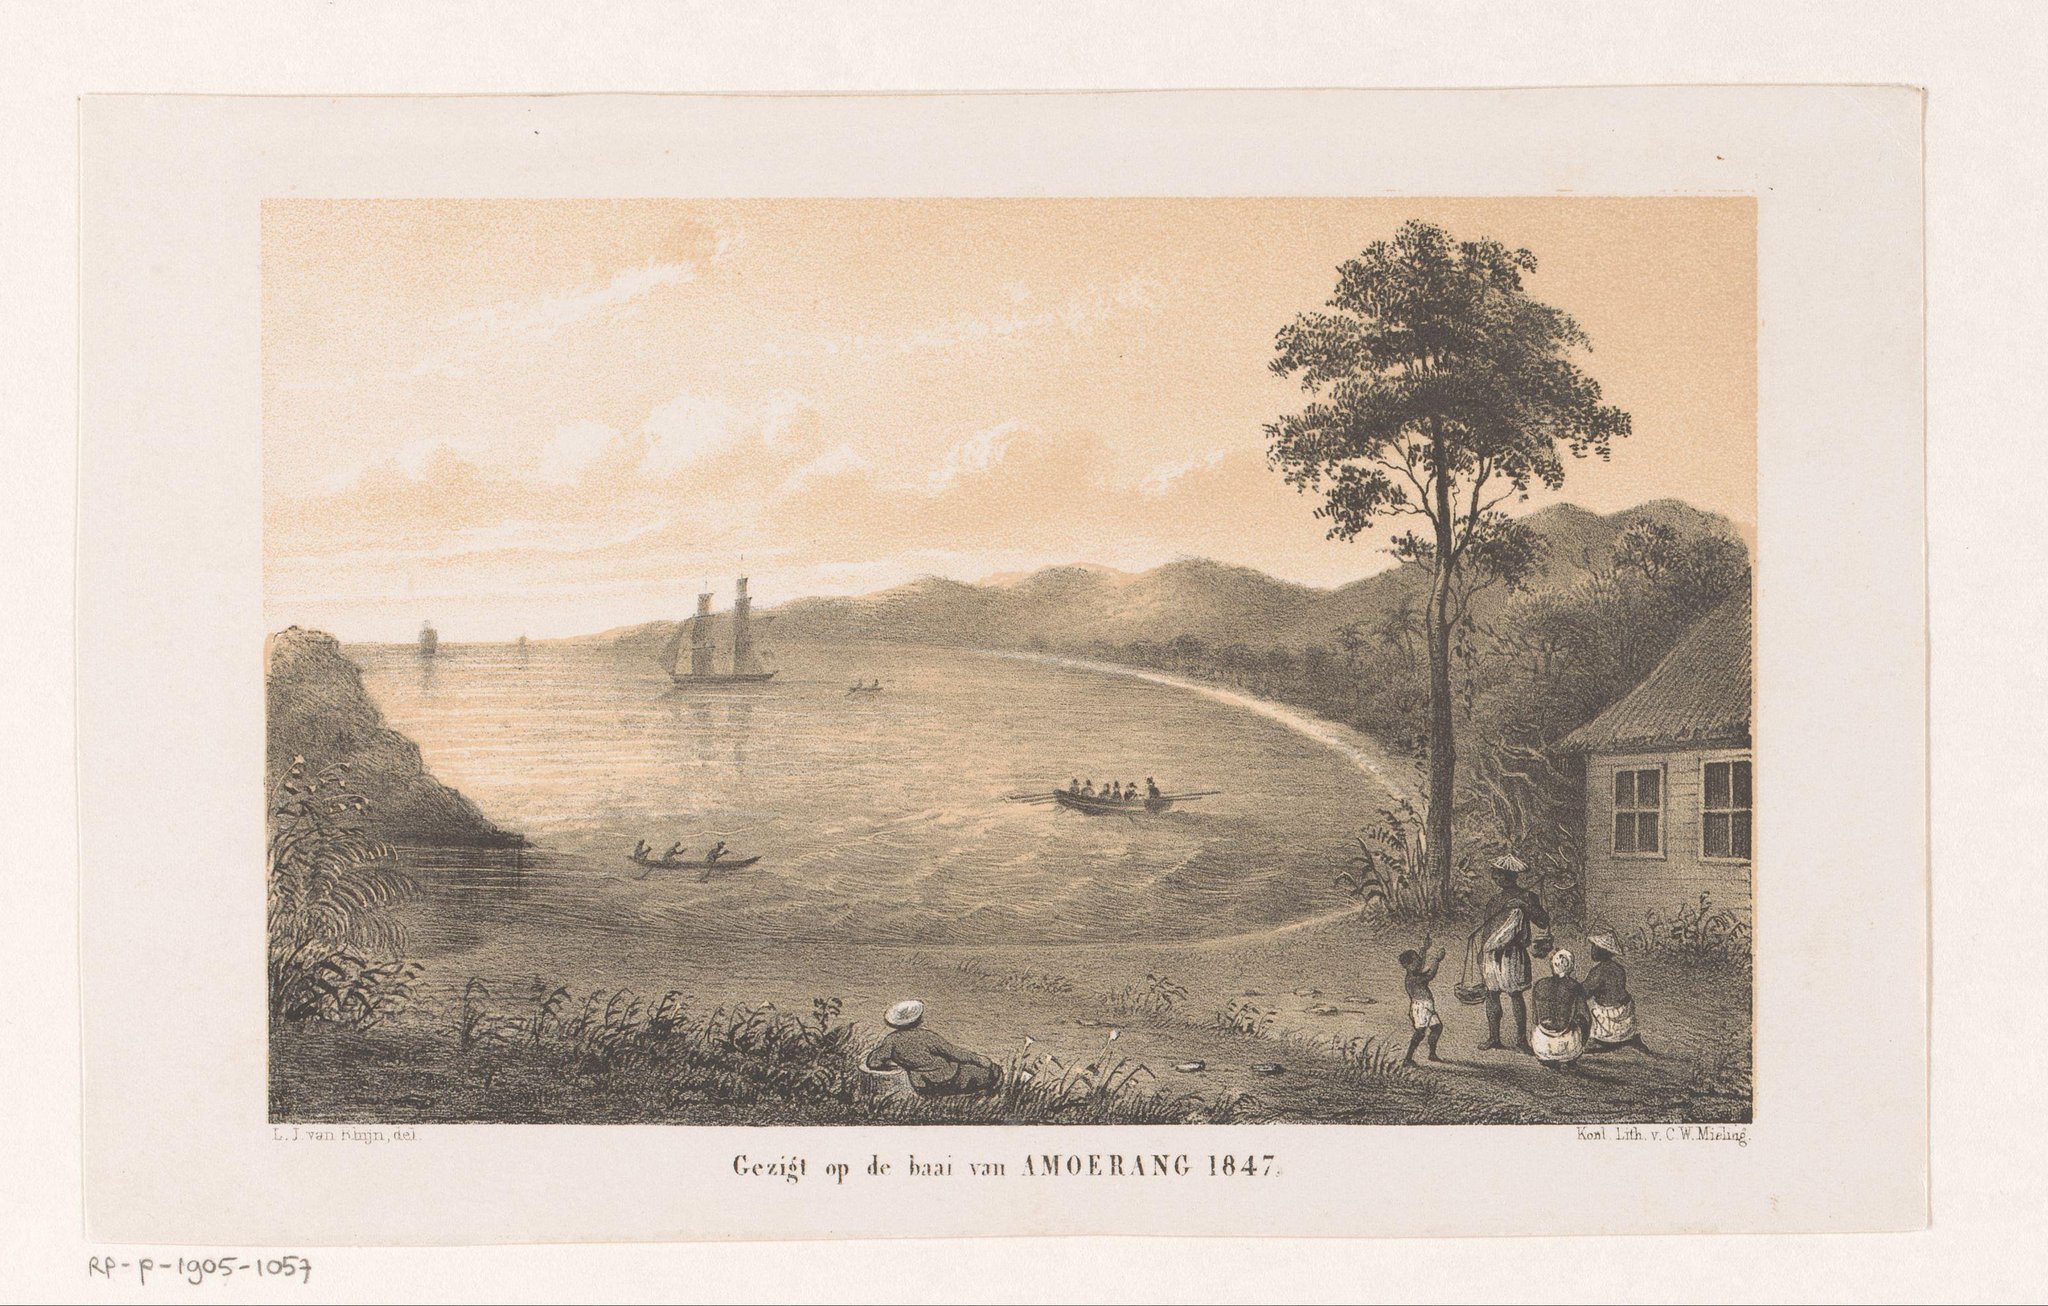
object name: print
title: Gezigt op de baai van Amoerang 1847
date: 1851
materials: paper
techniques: tone lithography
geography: indonesia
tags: indonesia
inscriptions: collector's mark: Lugt 2228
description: Gepubliceerd in: L.J. van Rhijn, Reis door den Indischen archipel in het belang der Evangelische Zending: Uitgegeven ten voordeele van dat genootschap. Rotterdam, Wyt & Zn.: 1851.